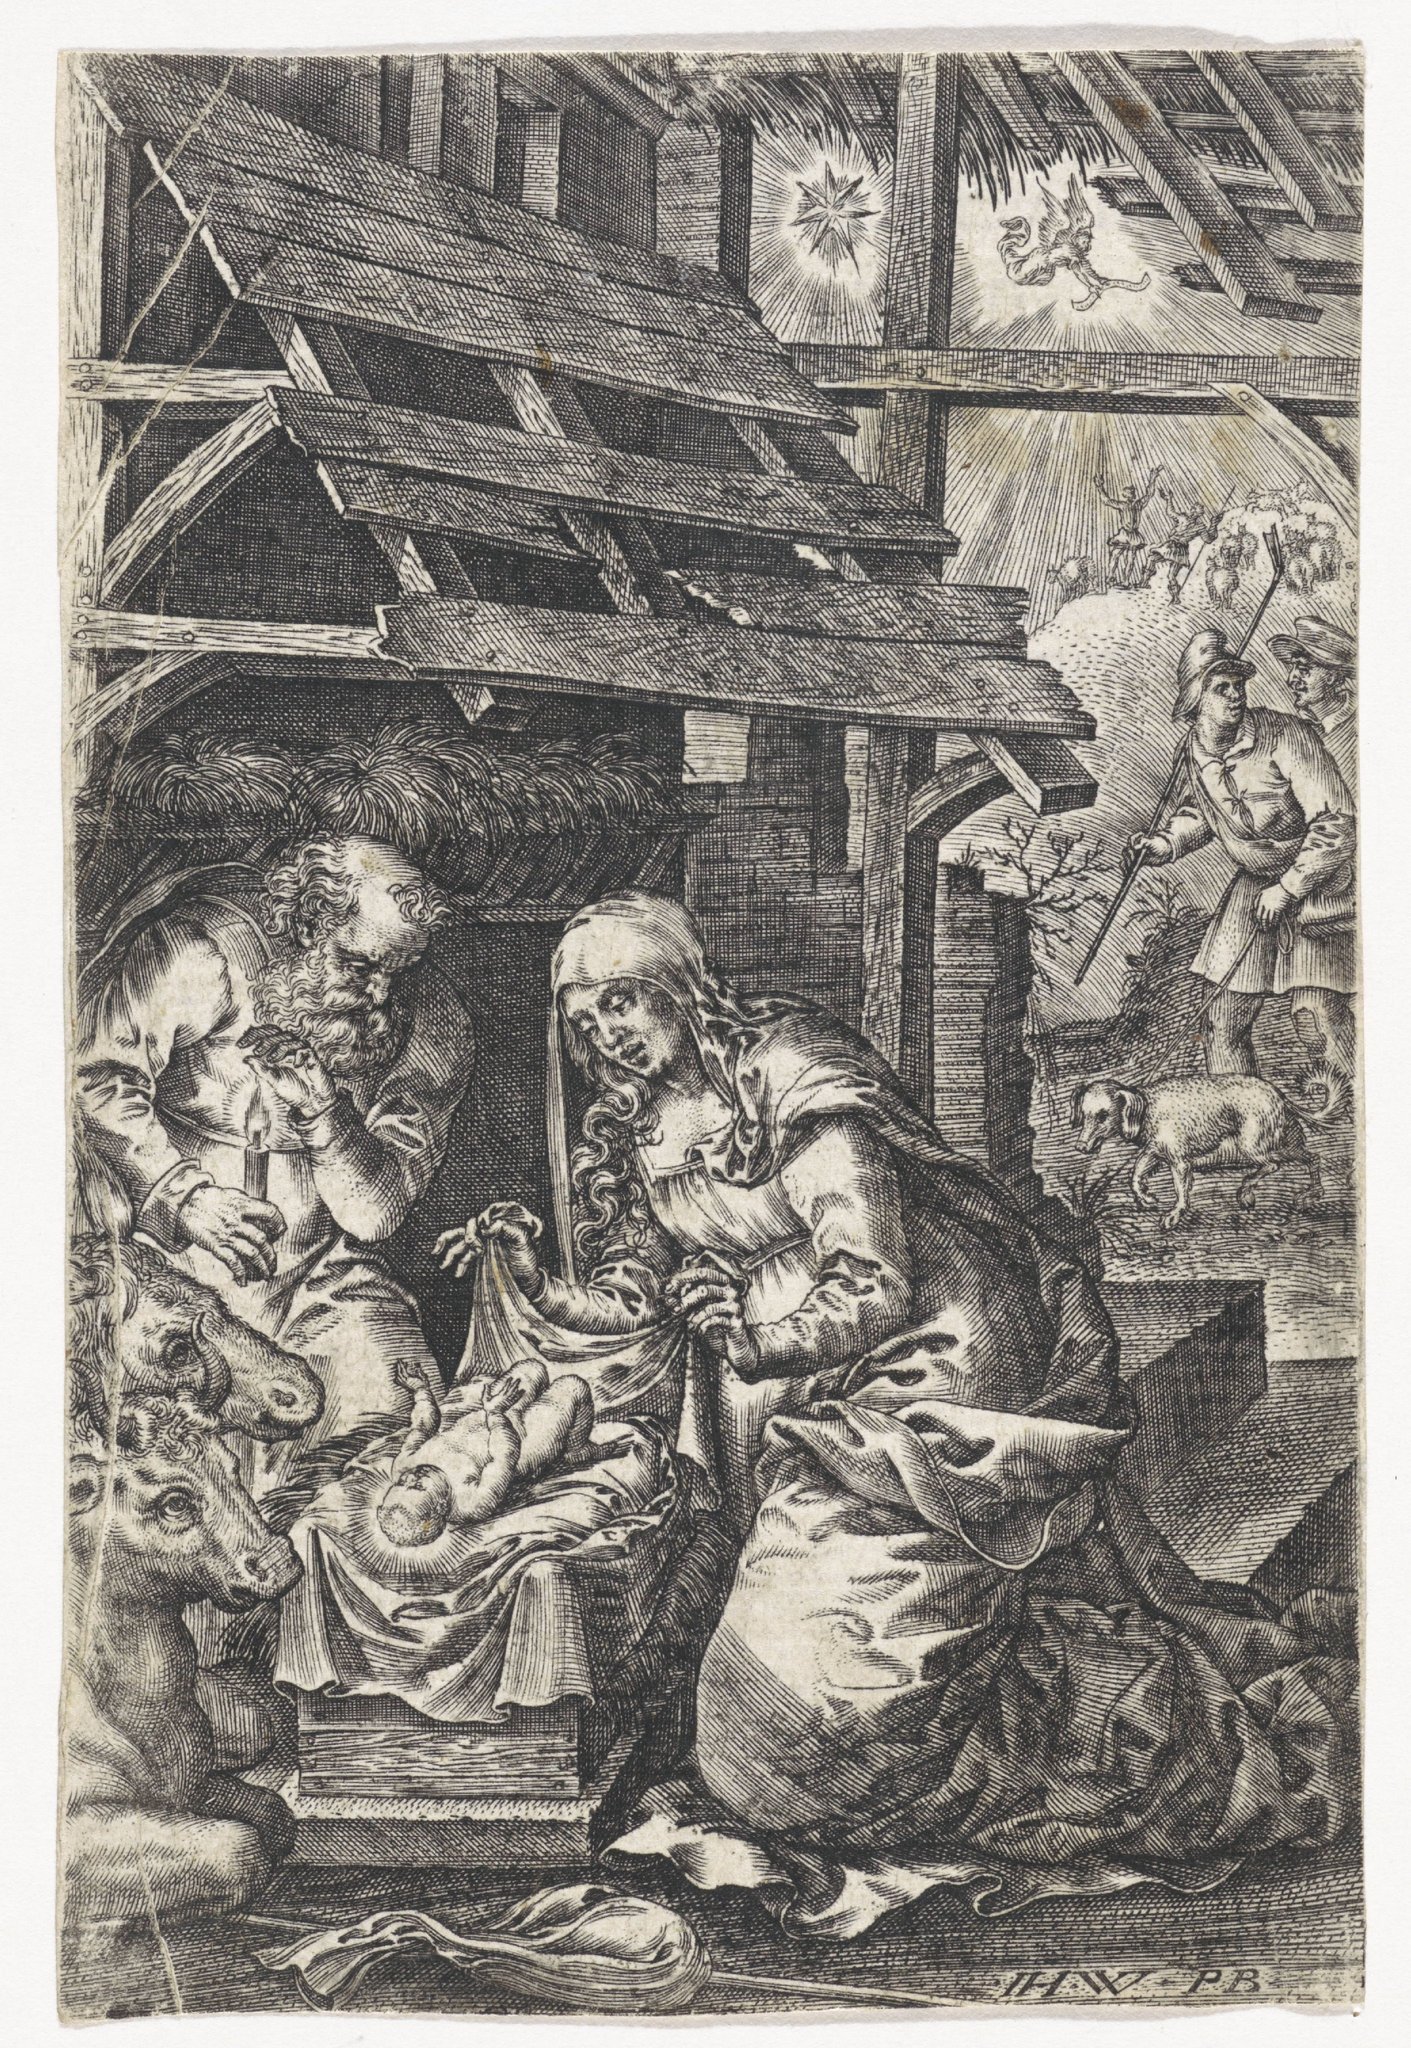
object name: print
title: Geboorte van Christus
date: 1573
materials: paper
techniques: engraving, letterpress printing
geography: antwerp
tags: the annunciation: mary, usually reading, is visited by the angel (sometimes a woman overhears the conversation), mary, joseph and the new-born christ (nativity), dog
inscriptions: collector's mark: Lugt 2228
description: Maria legt een laken over het Christuskind. Jozef beschut met zijn hand de vlam van de kaars. De os en de ezel liggen naast de kribbe in de stal. Op de achtergrond twee herders met een hond en de verkondiging aan de herders.